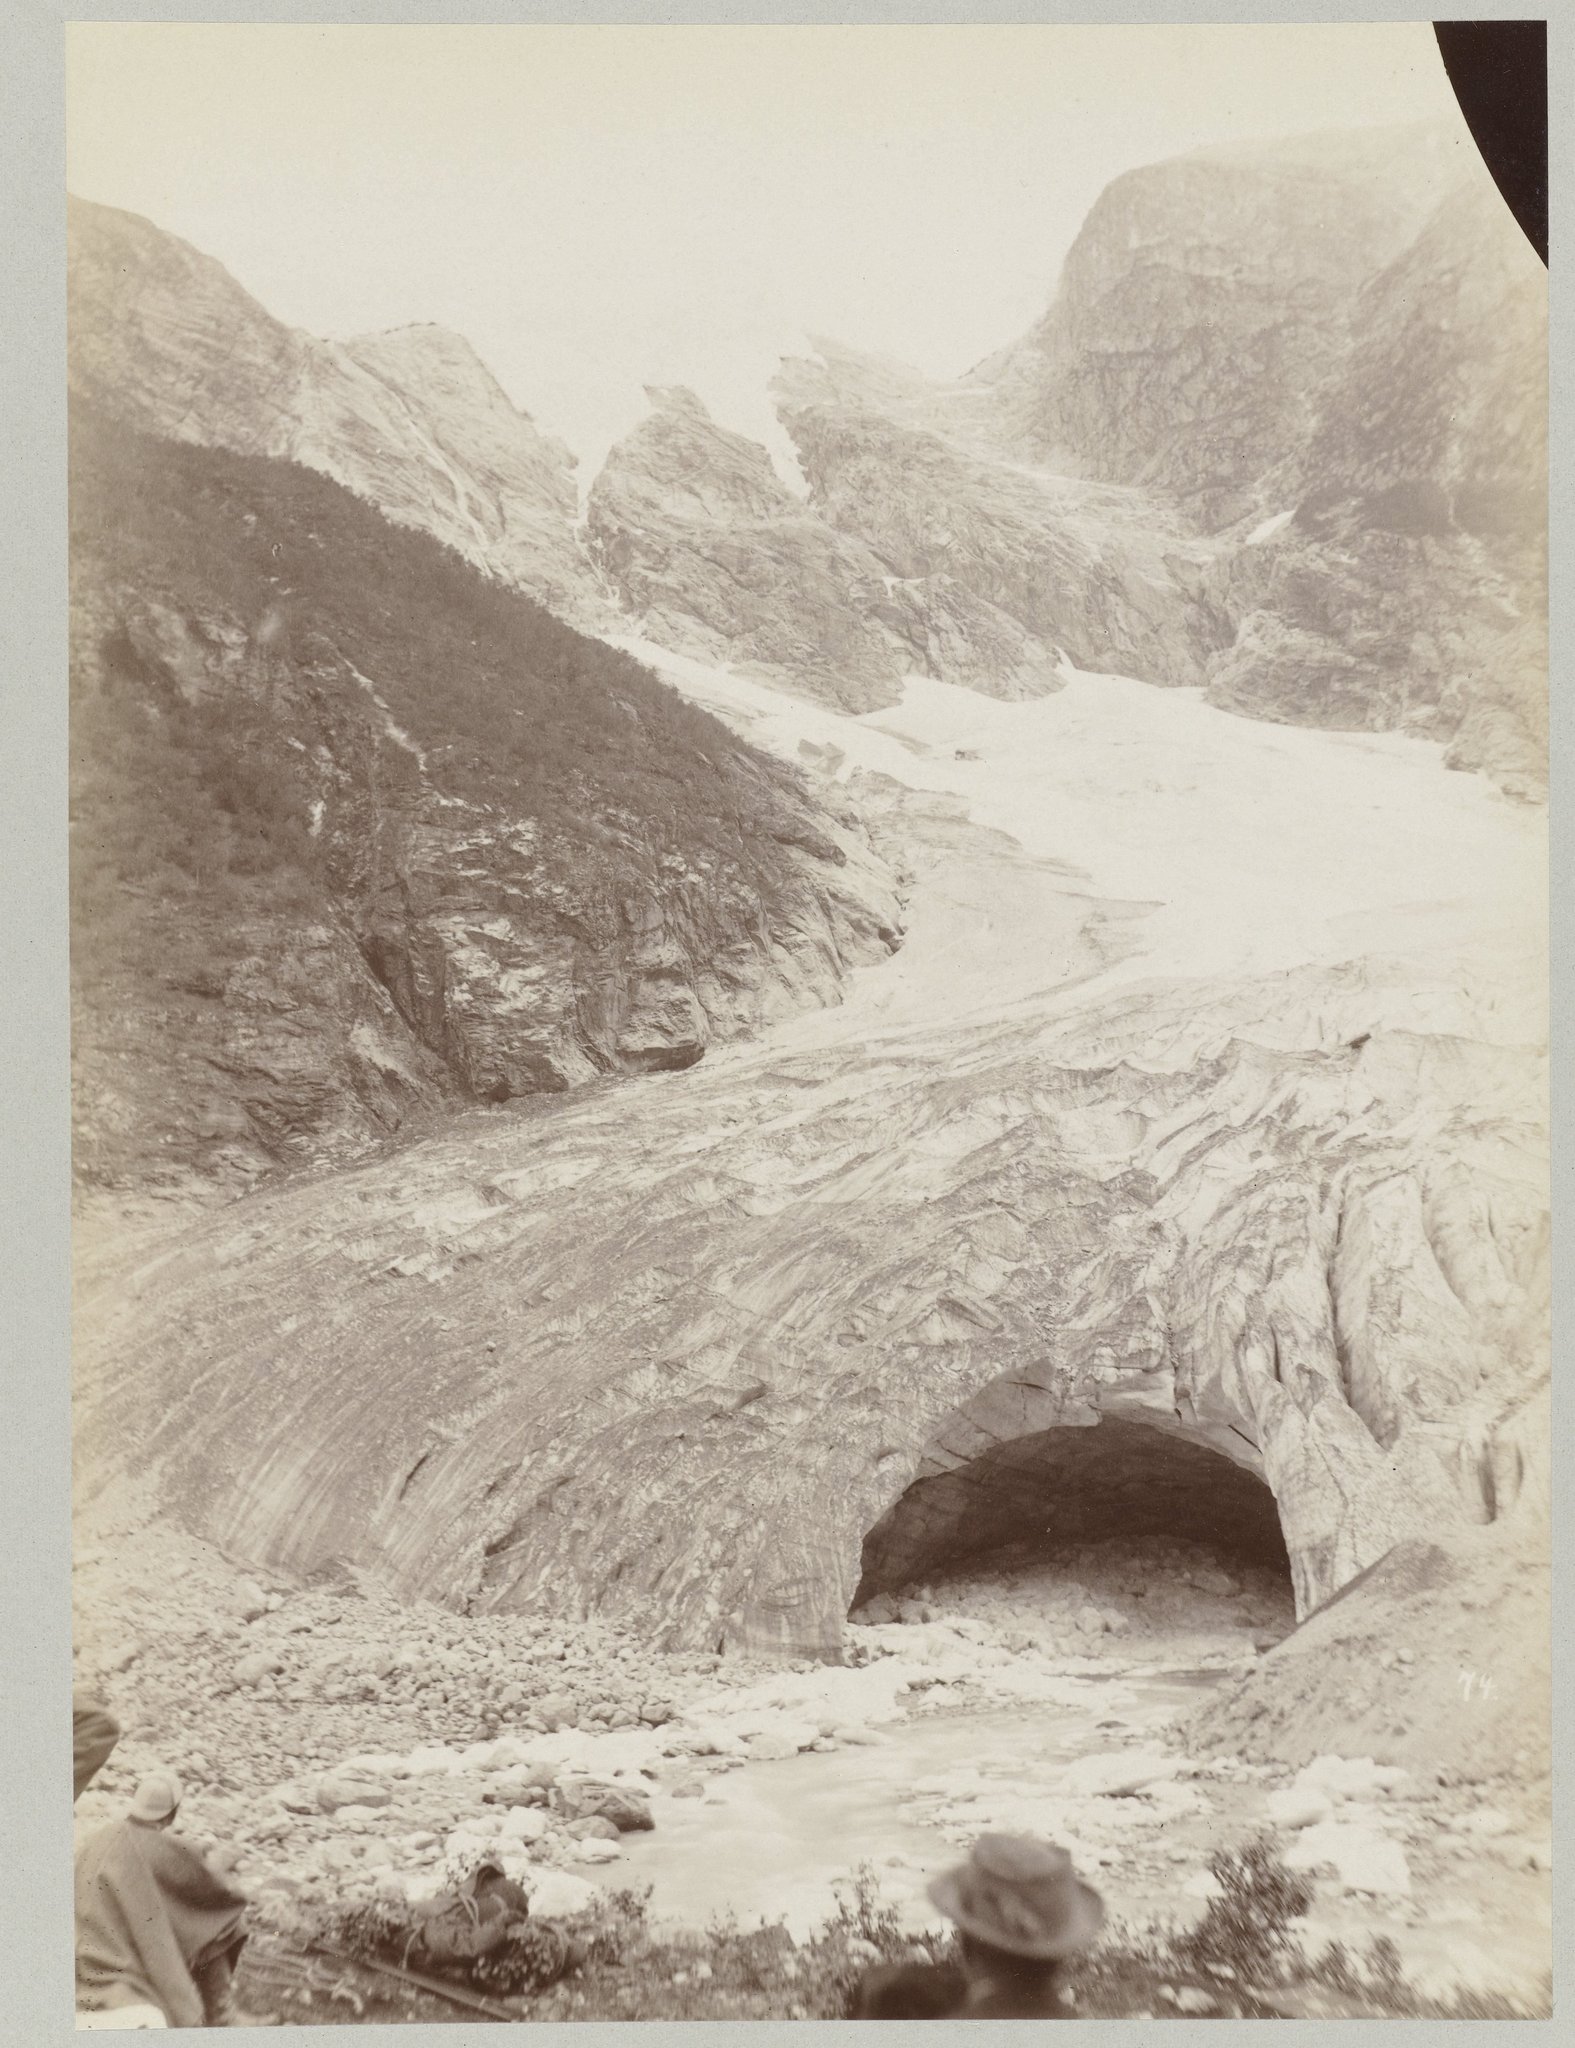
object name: photograph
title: Kaiser Wilhelm II am Fuss des Suphell-Gletschers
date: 1807-1889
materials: cardboard, paper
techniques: albumen print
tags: wilhelm ii (keizer van duitsland), norway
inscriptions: number: ‘74’, number: ‘18’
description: De afdruk van de foto is rond, het papier vierkant